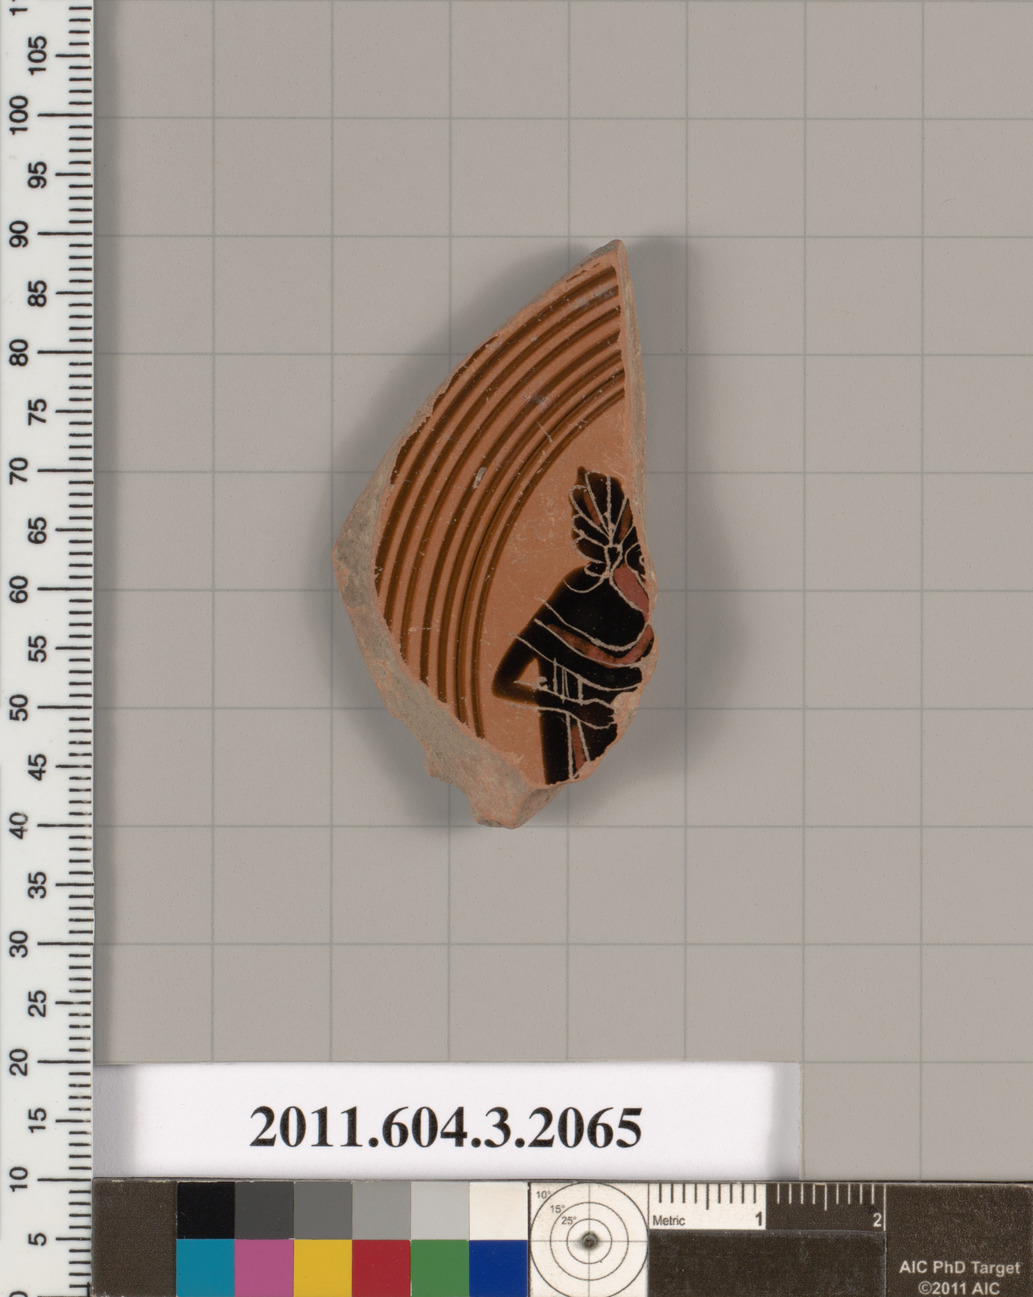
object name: kylix fragment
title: Terracotta fragment of a kylix (drinking cup)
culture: greek, attic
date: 525-501 BCE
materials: terracotta